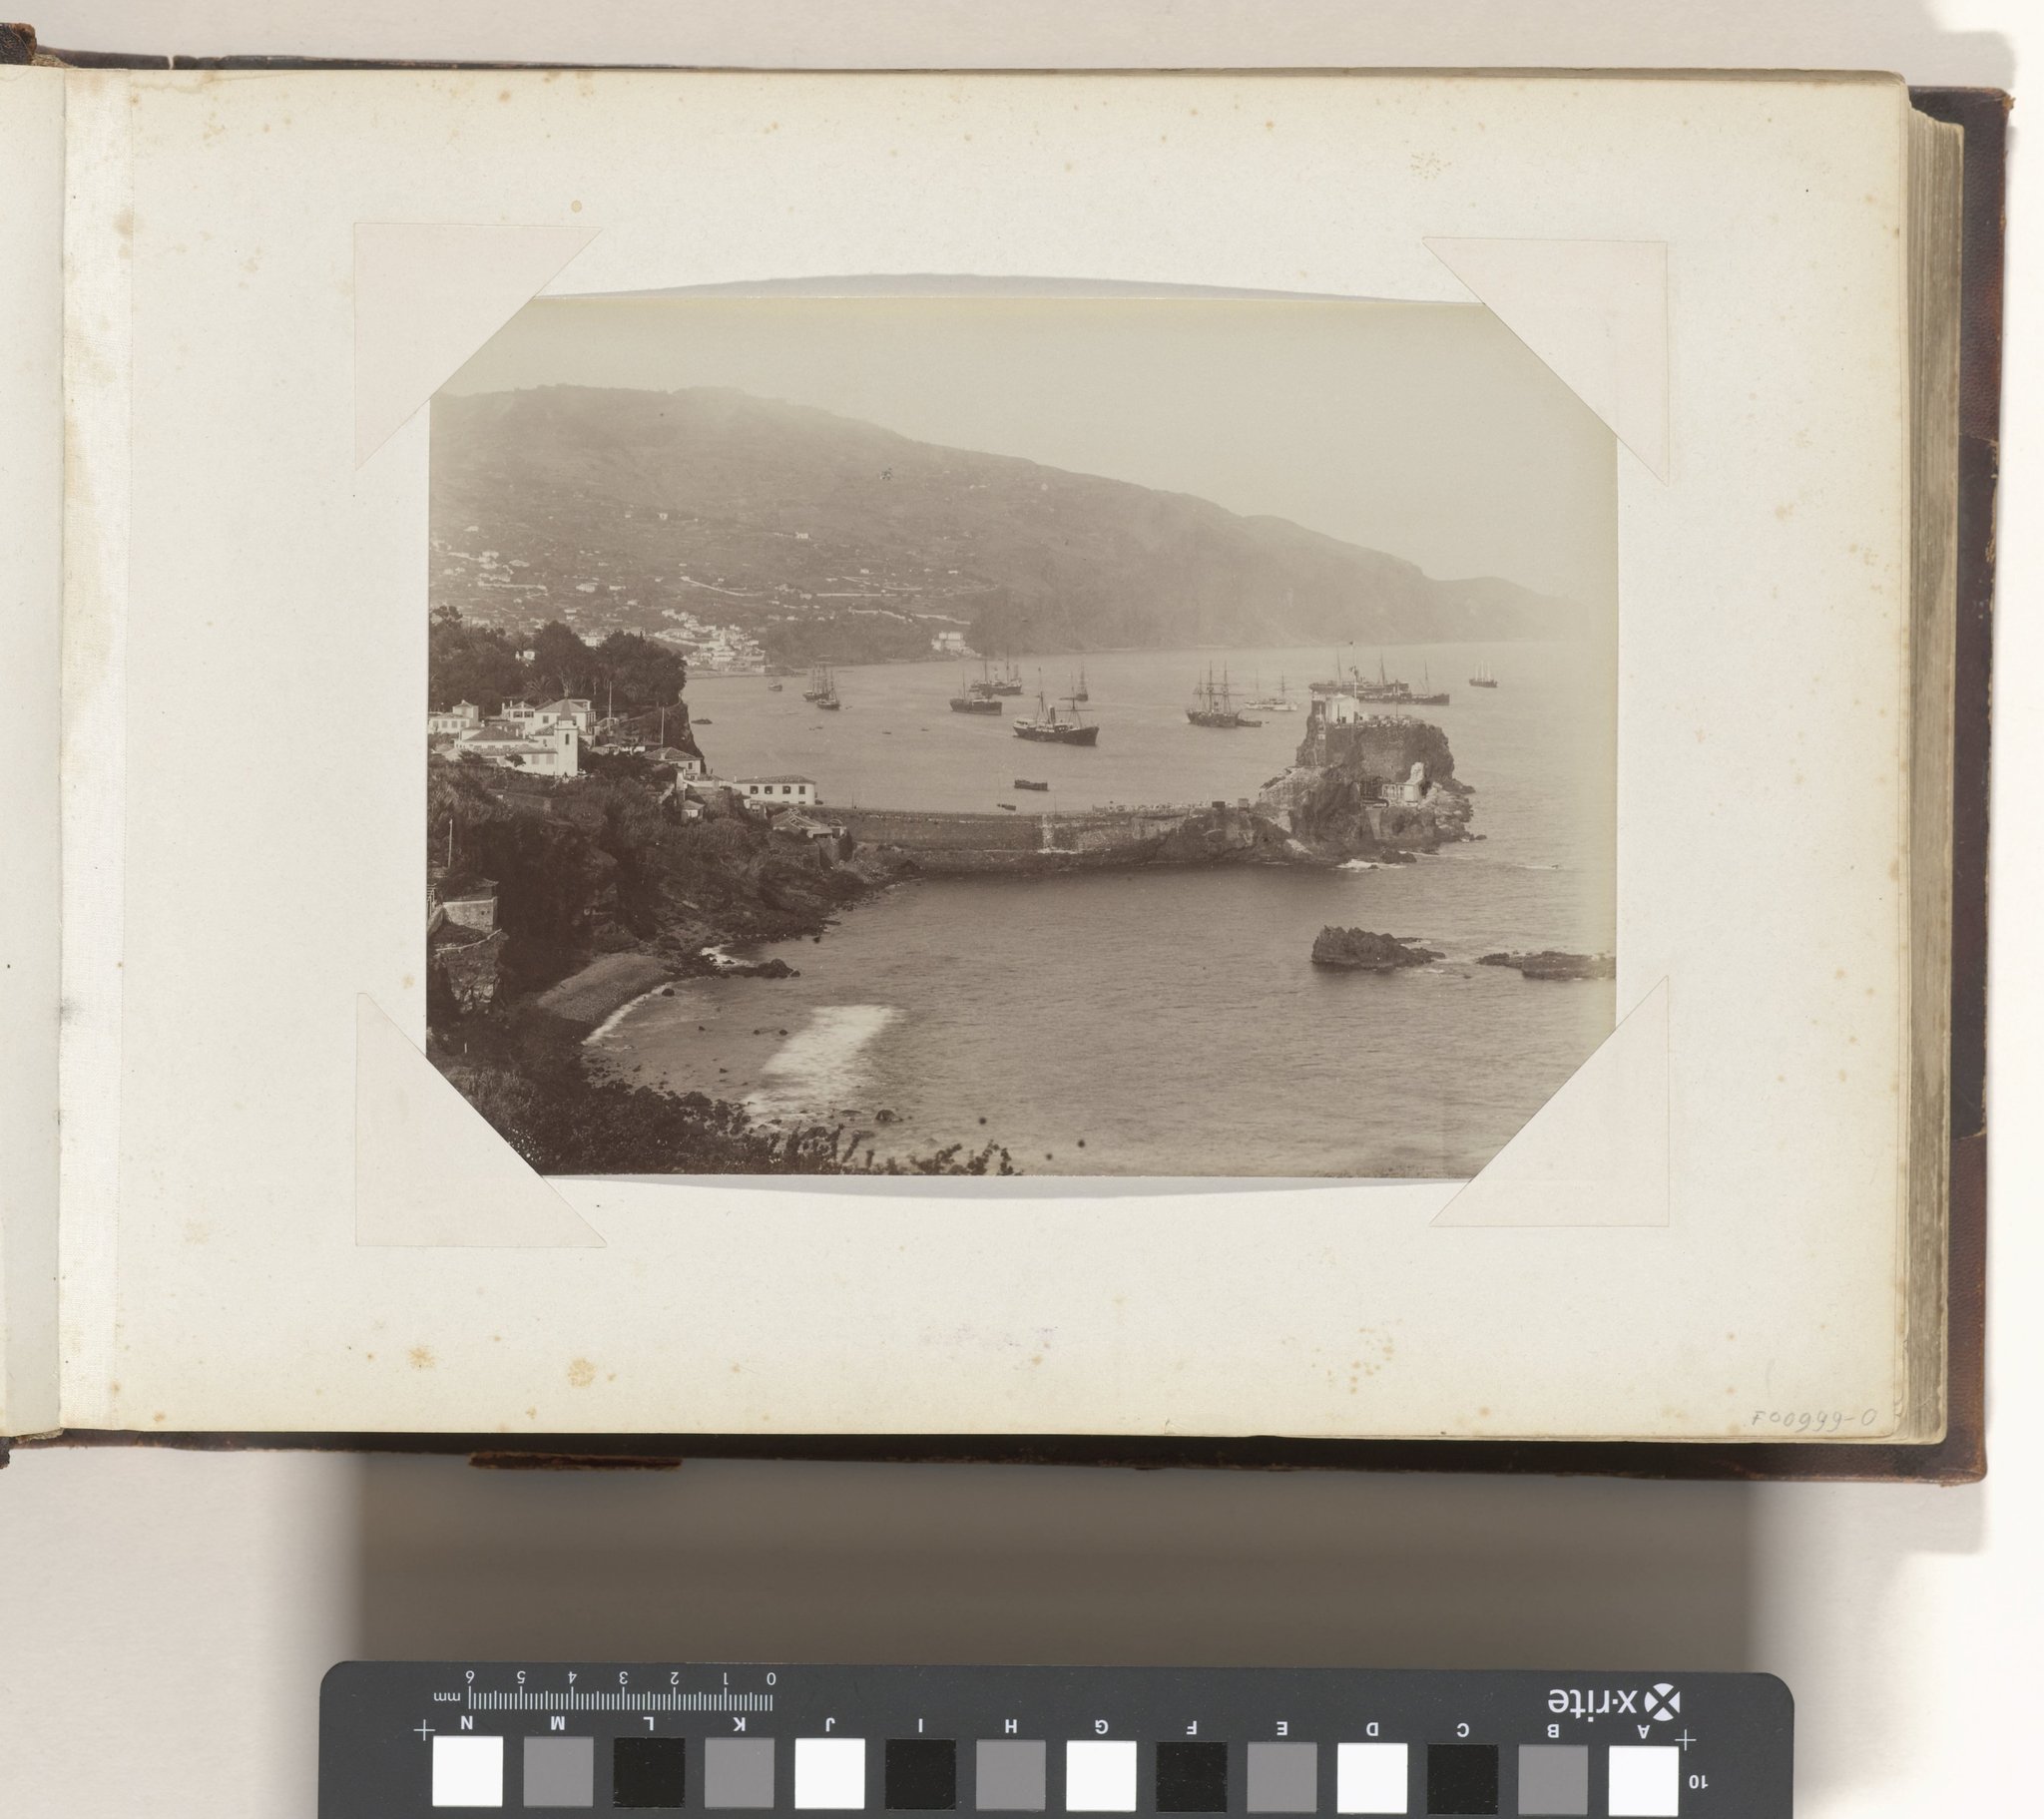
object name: photograph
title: Gezicht op de kust en een havenpier van Madeira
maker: Anonymous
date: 1885-1910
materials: paper, photographic support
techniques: albumen print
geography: madeira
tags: pier, quay, wharf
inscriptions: name: ‘[...] and Look-Book Madeira’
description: Onderdeel van Album met 191 foto's van een reis naar en door Zuid-Afrika.